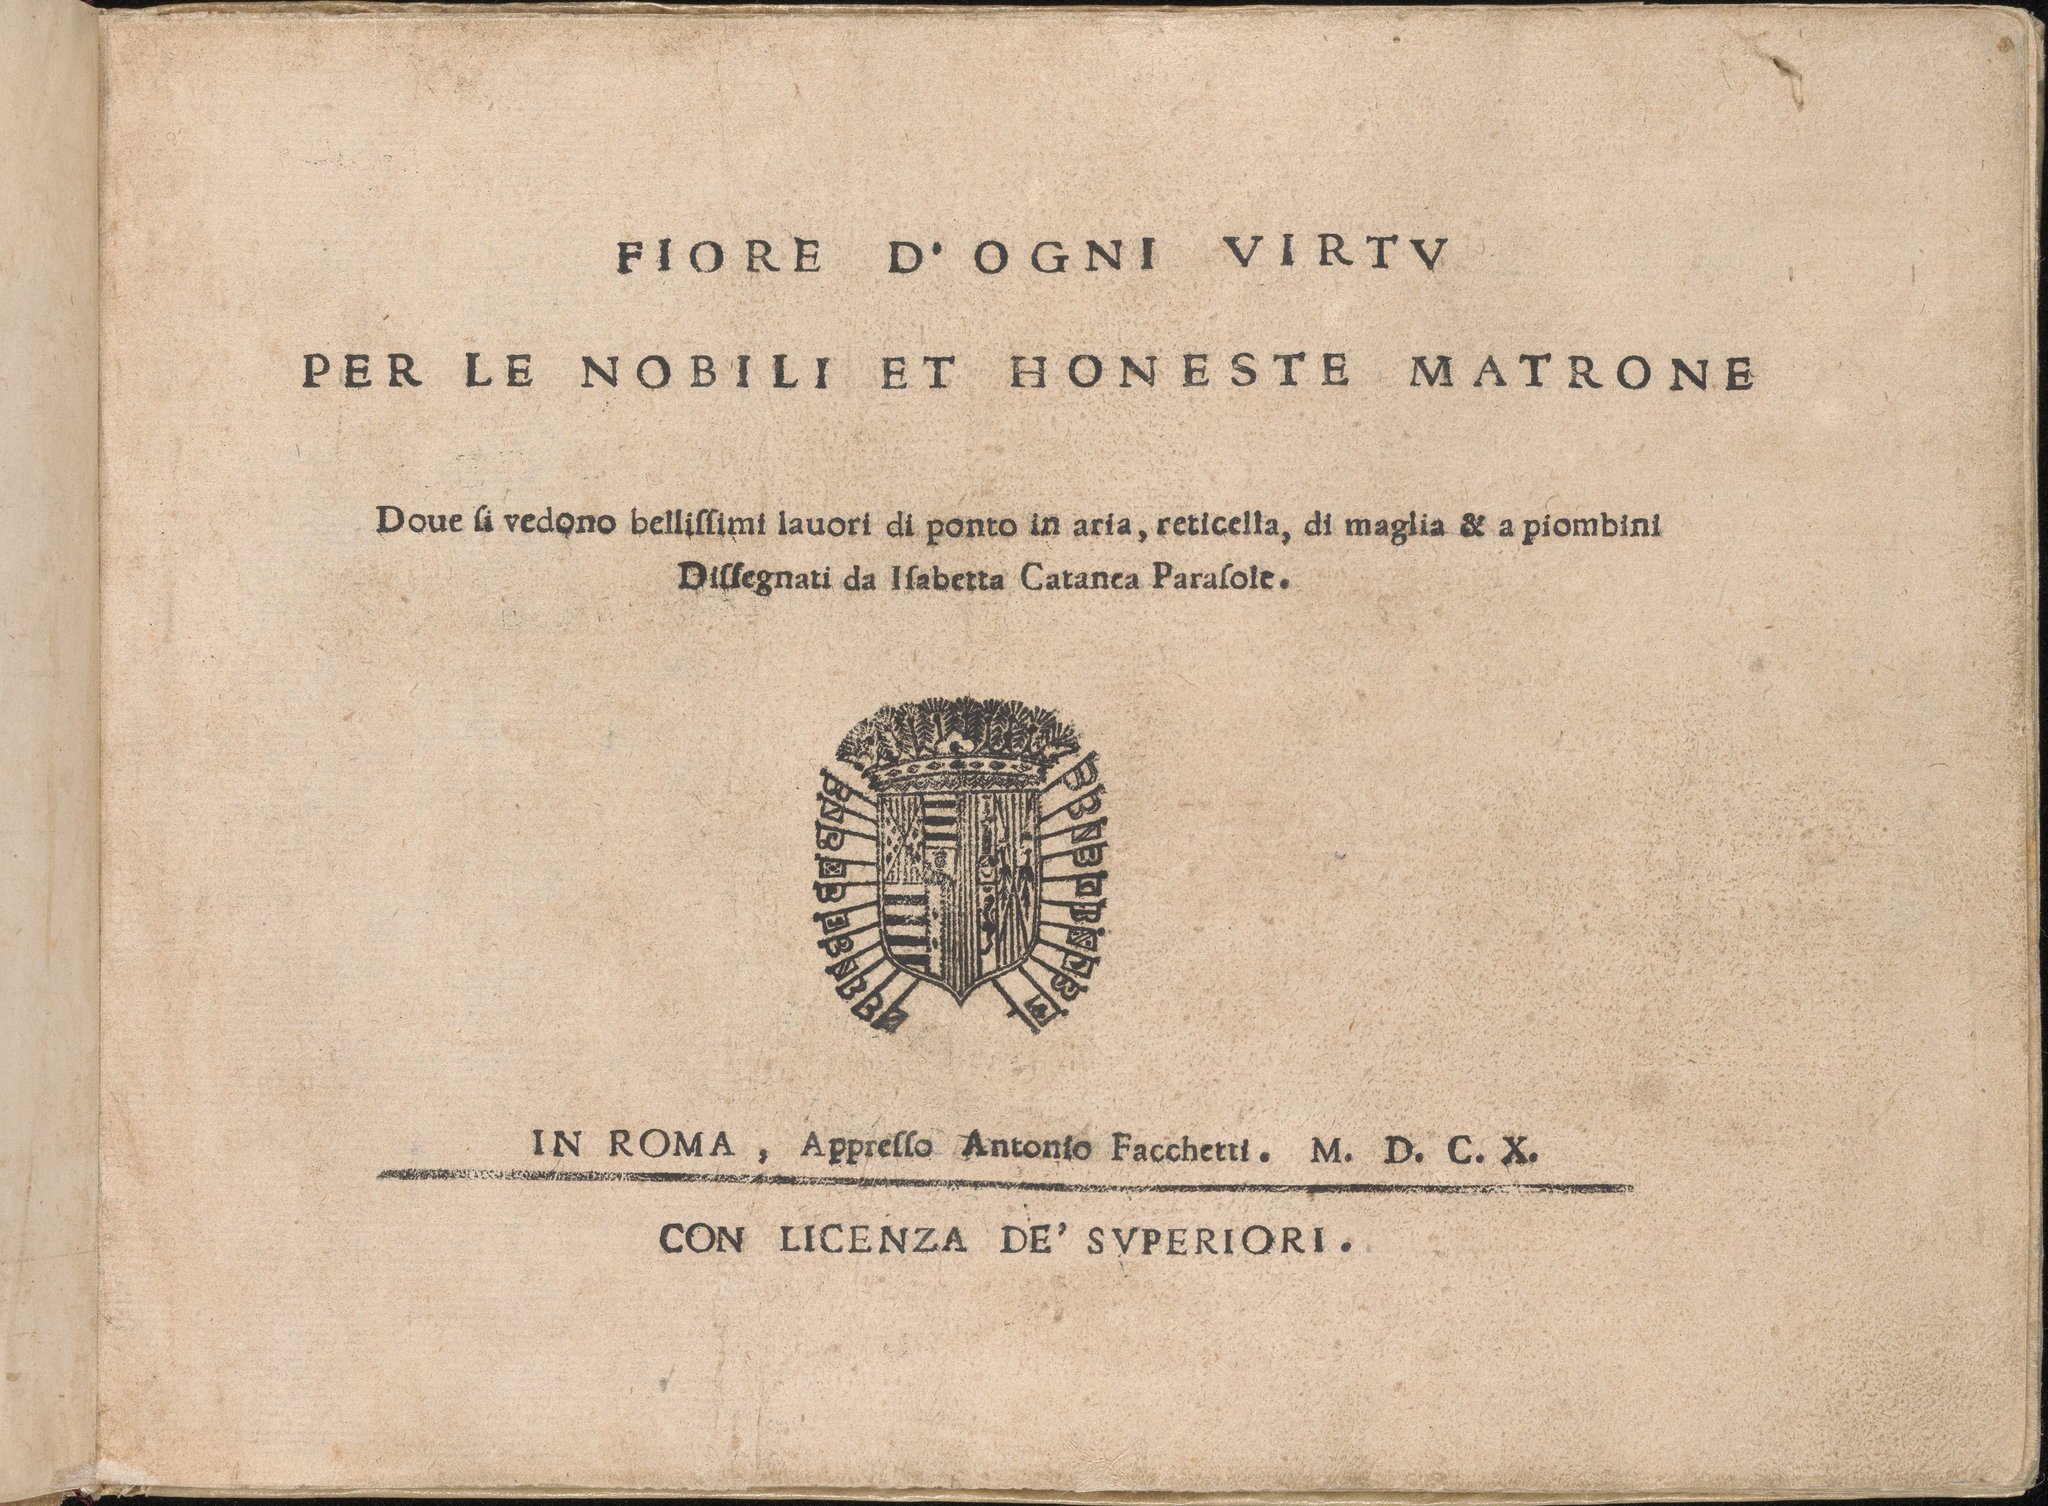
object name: book print ornament architecture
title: Fiore D'Ogni Virtu Per le Nobili Et Honeste Matrone, title page (recto)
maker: isabella catanea parasole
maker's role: designer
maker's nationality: italian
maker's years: 1565-1625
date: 1610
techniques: woodcut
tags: coat of arms